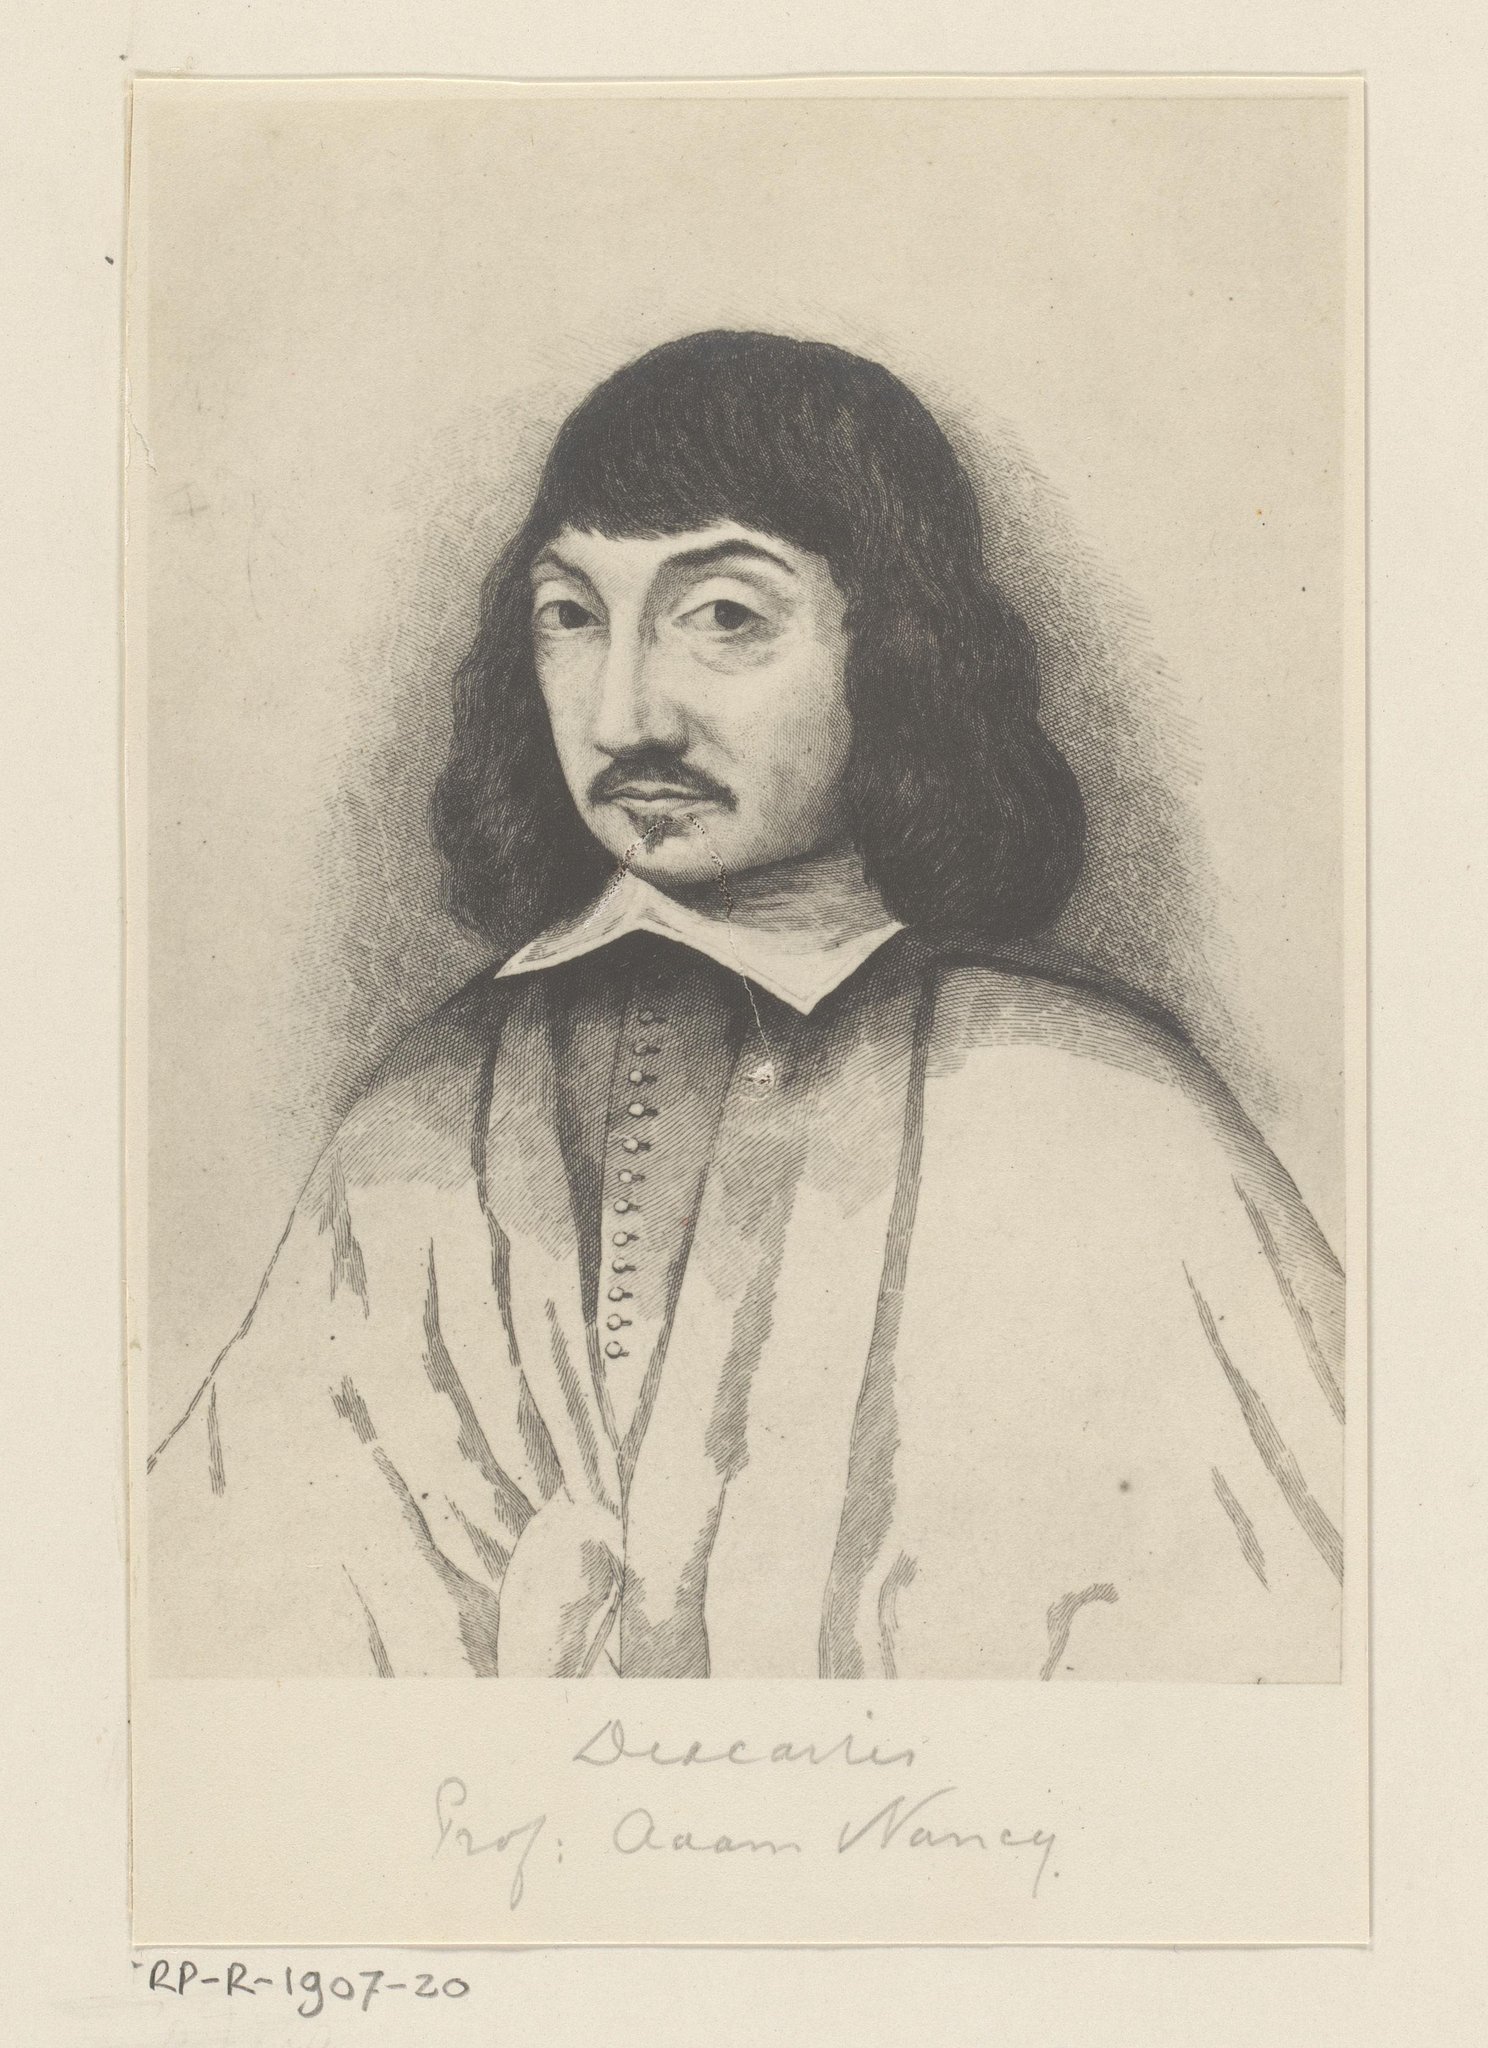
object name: reproduction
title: Fotoreproductie van een getekend portret van René Descartes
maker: Anonymous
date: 1885-1907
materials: paper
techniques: gelatin silver print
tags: rené descartes, scholar, philosopher, historical persons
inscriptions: inscription: ‘Descartes/ Prof. Adam Nancy.’